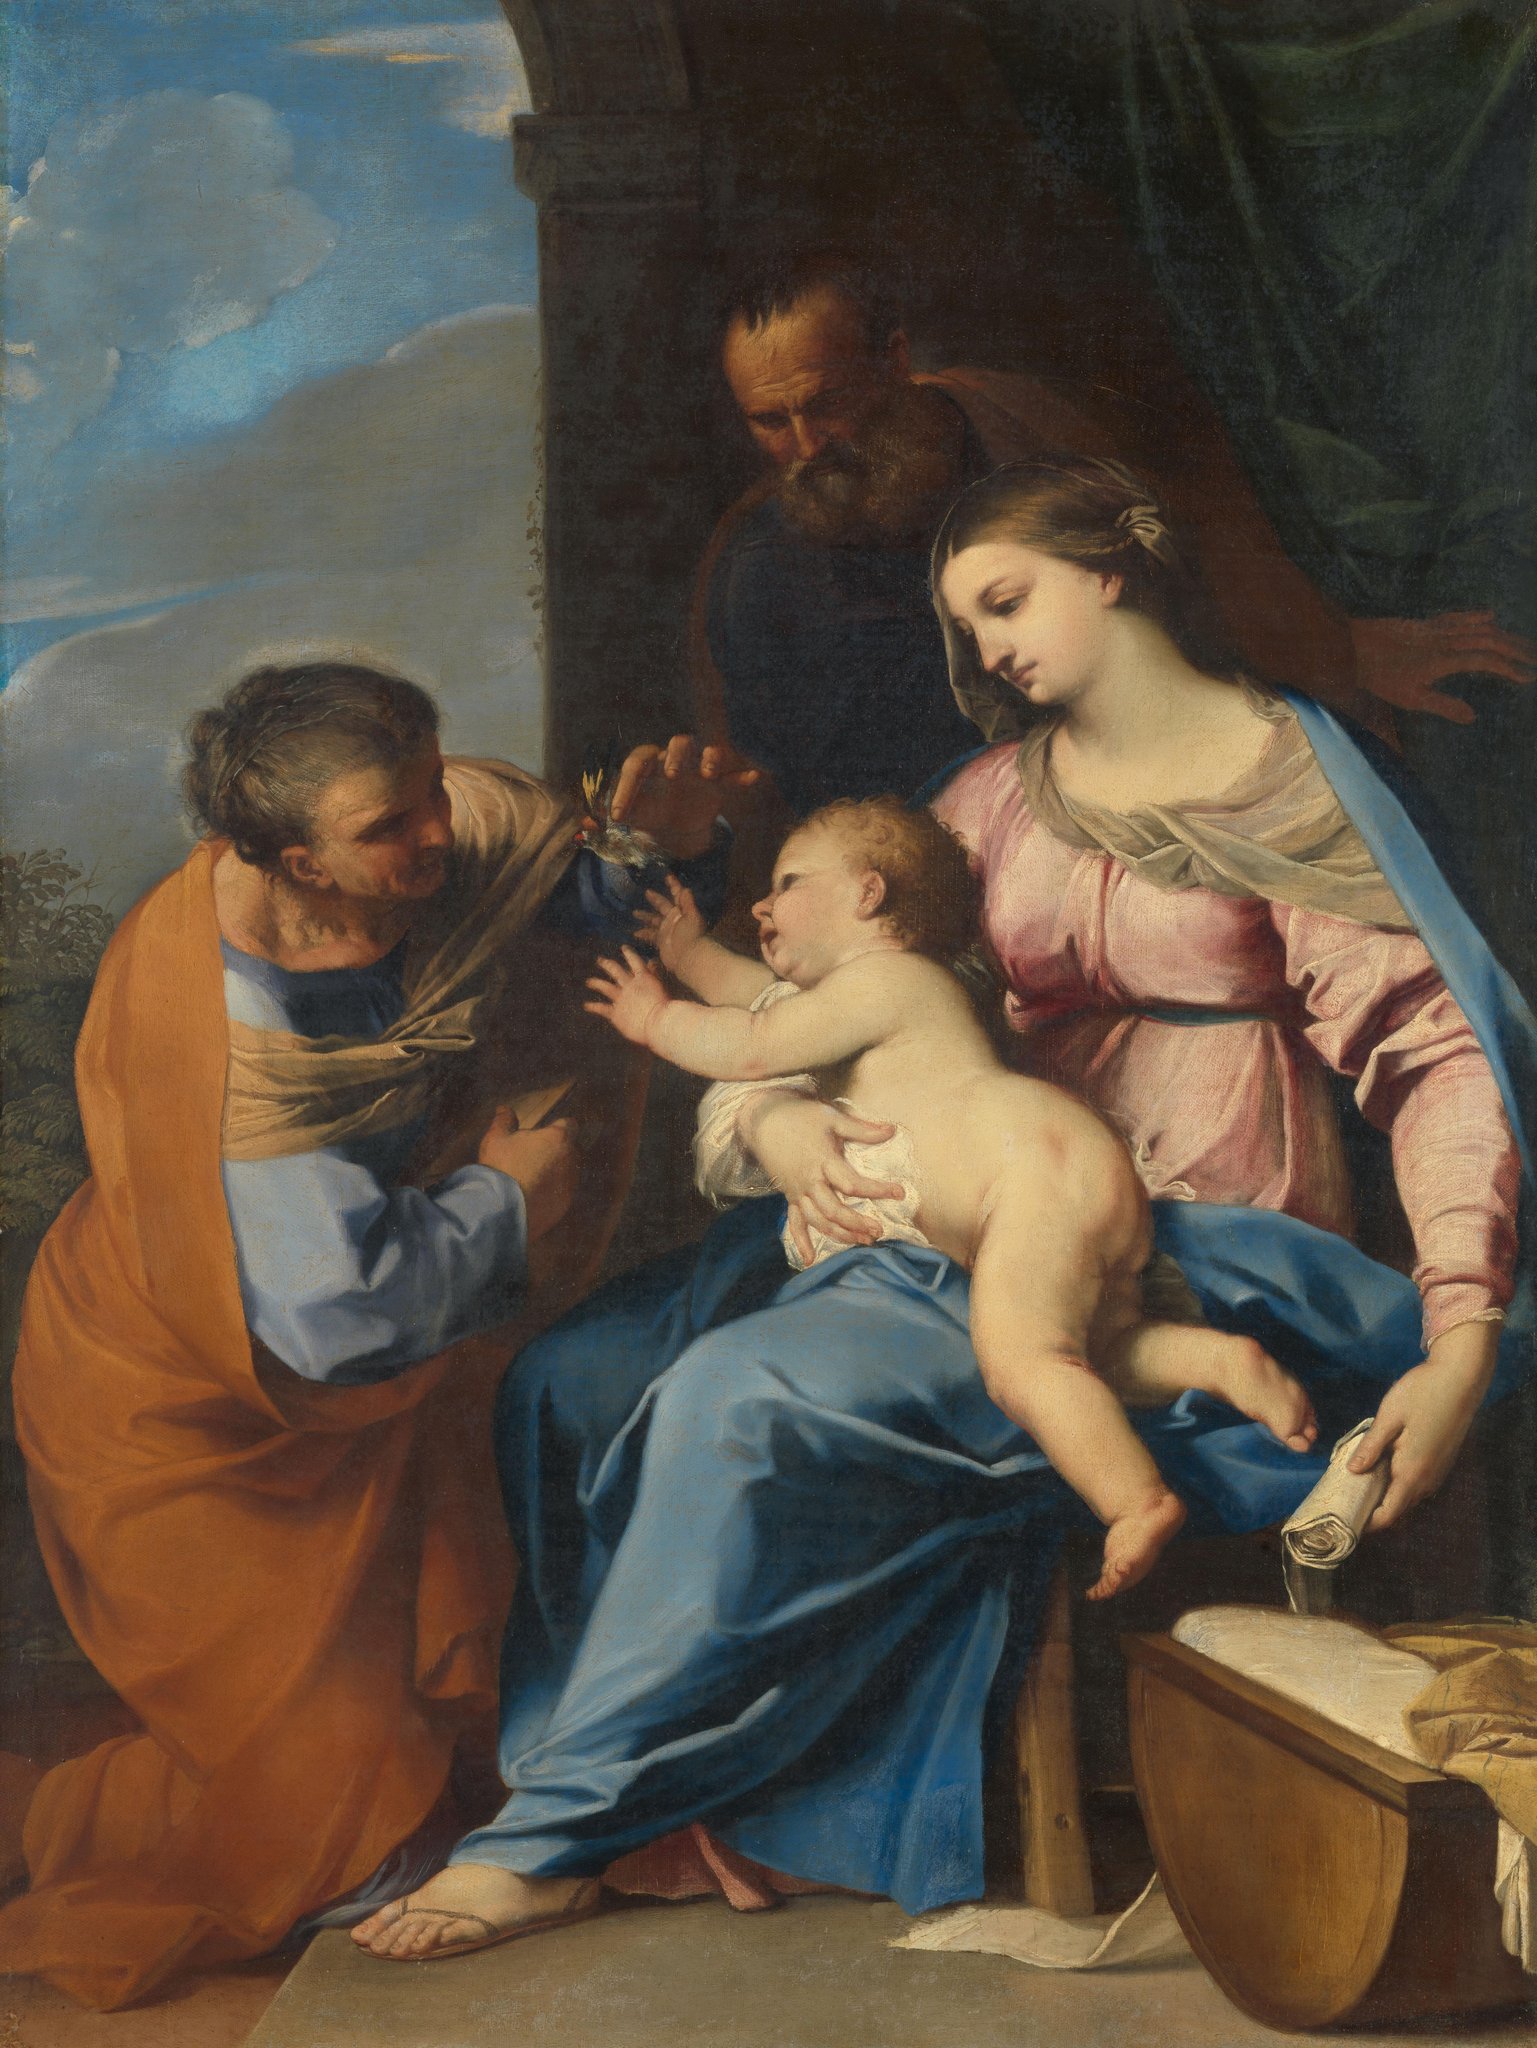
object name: painting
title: The Holy Family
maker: raffaello vanni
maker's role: painter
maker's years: 1587-1678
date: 1640-1660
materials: canvas, oil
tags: holy family with others, e.g.: anna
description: Attributed to Raffaello Vanni (1587 - 1673). Holy family with St Anne, c. 1655. Purchased by King Willem I, 1823. On loan from the Mauritshuis, The Hague, 1948.